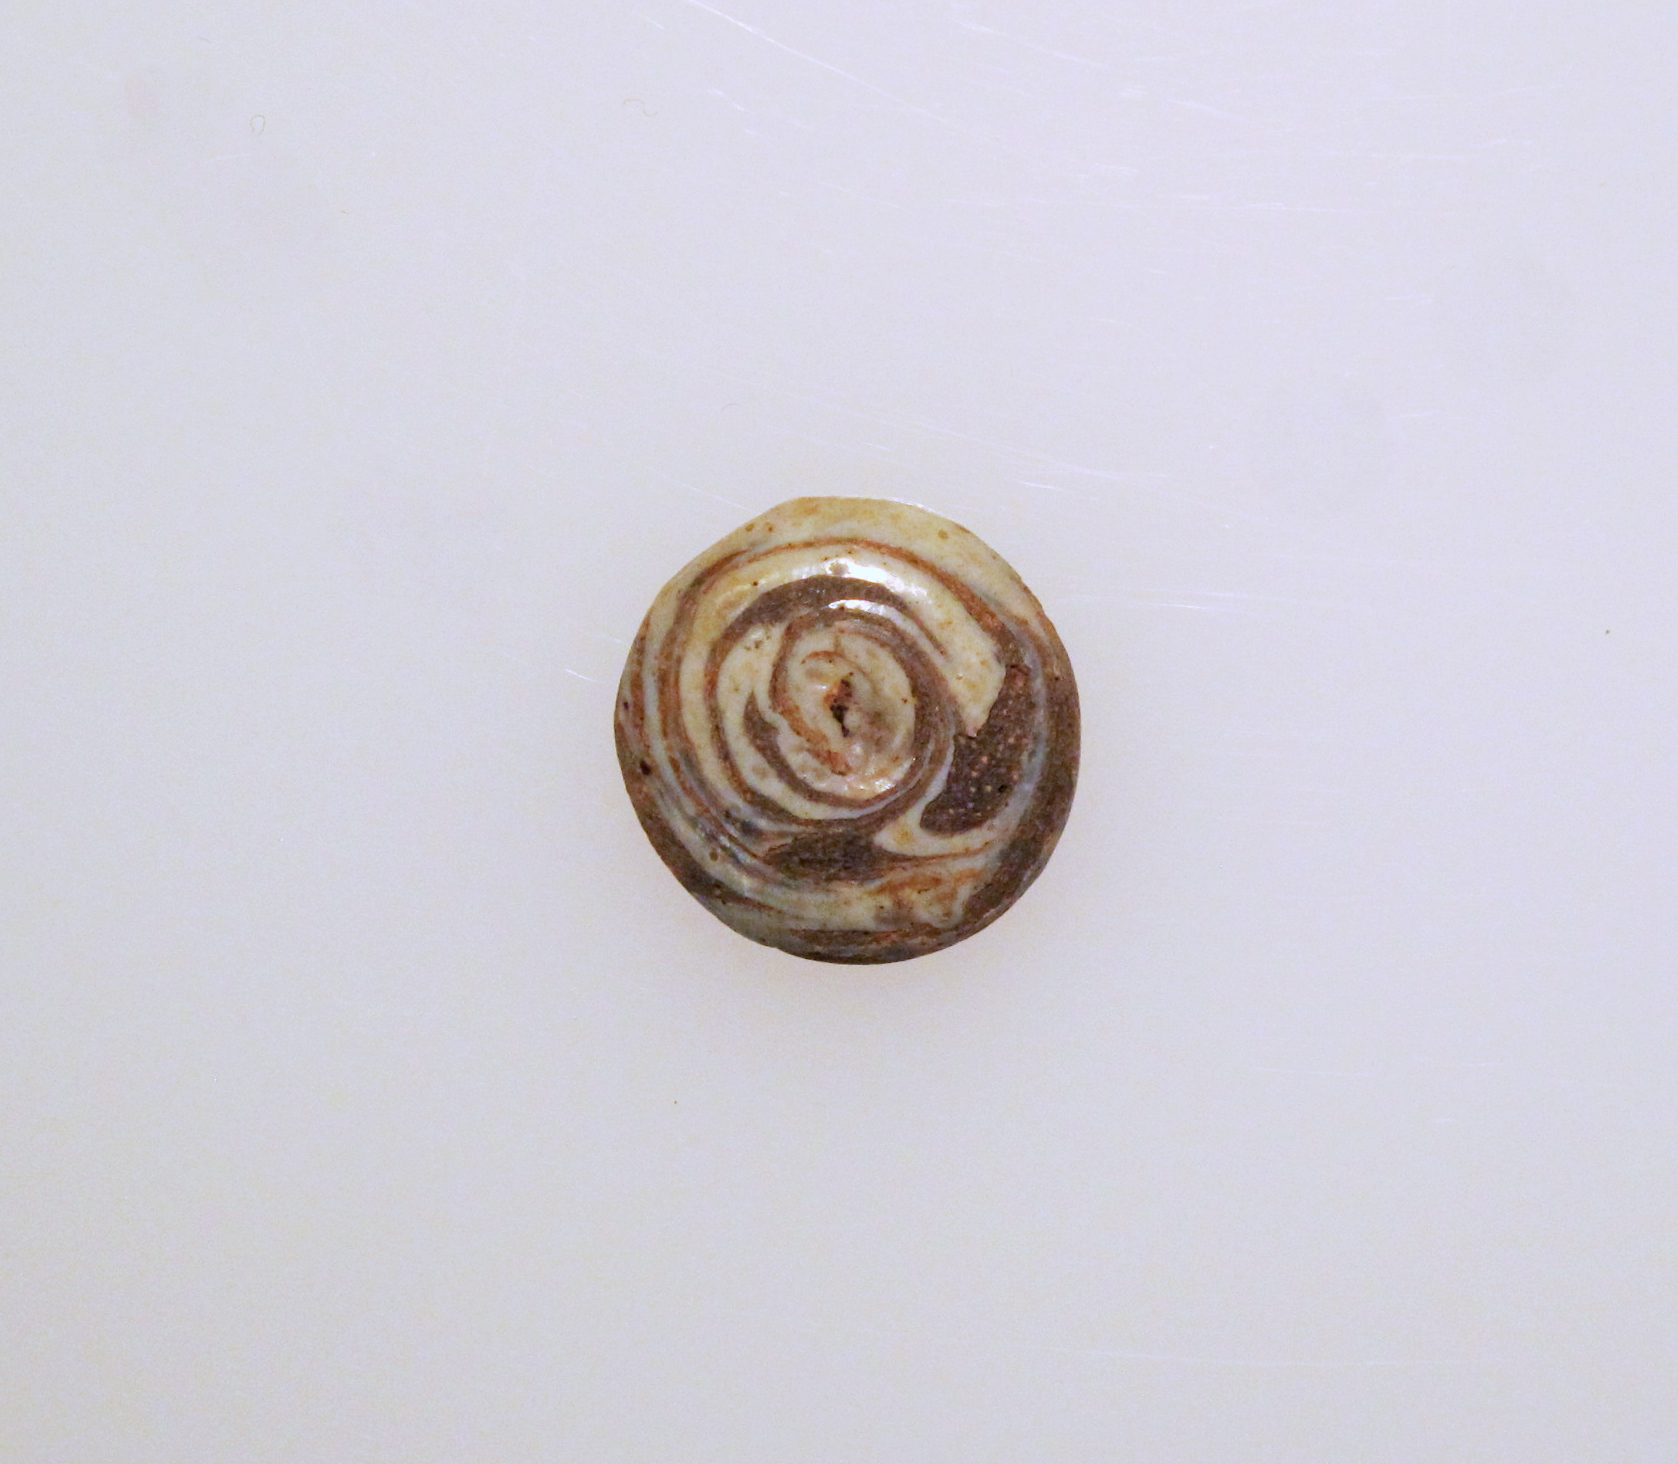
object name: pinhead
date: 7000 BCE-330 CE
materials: glass